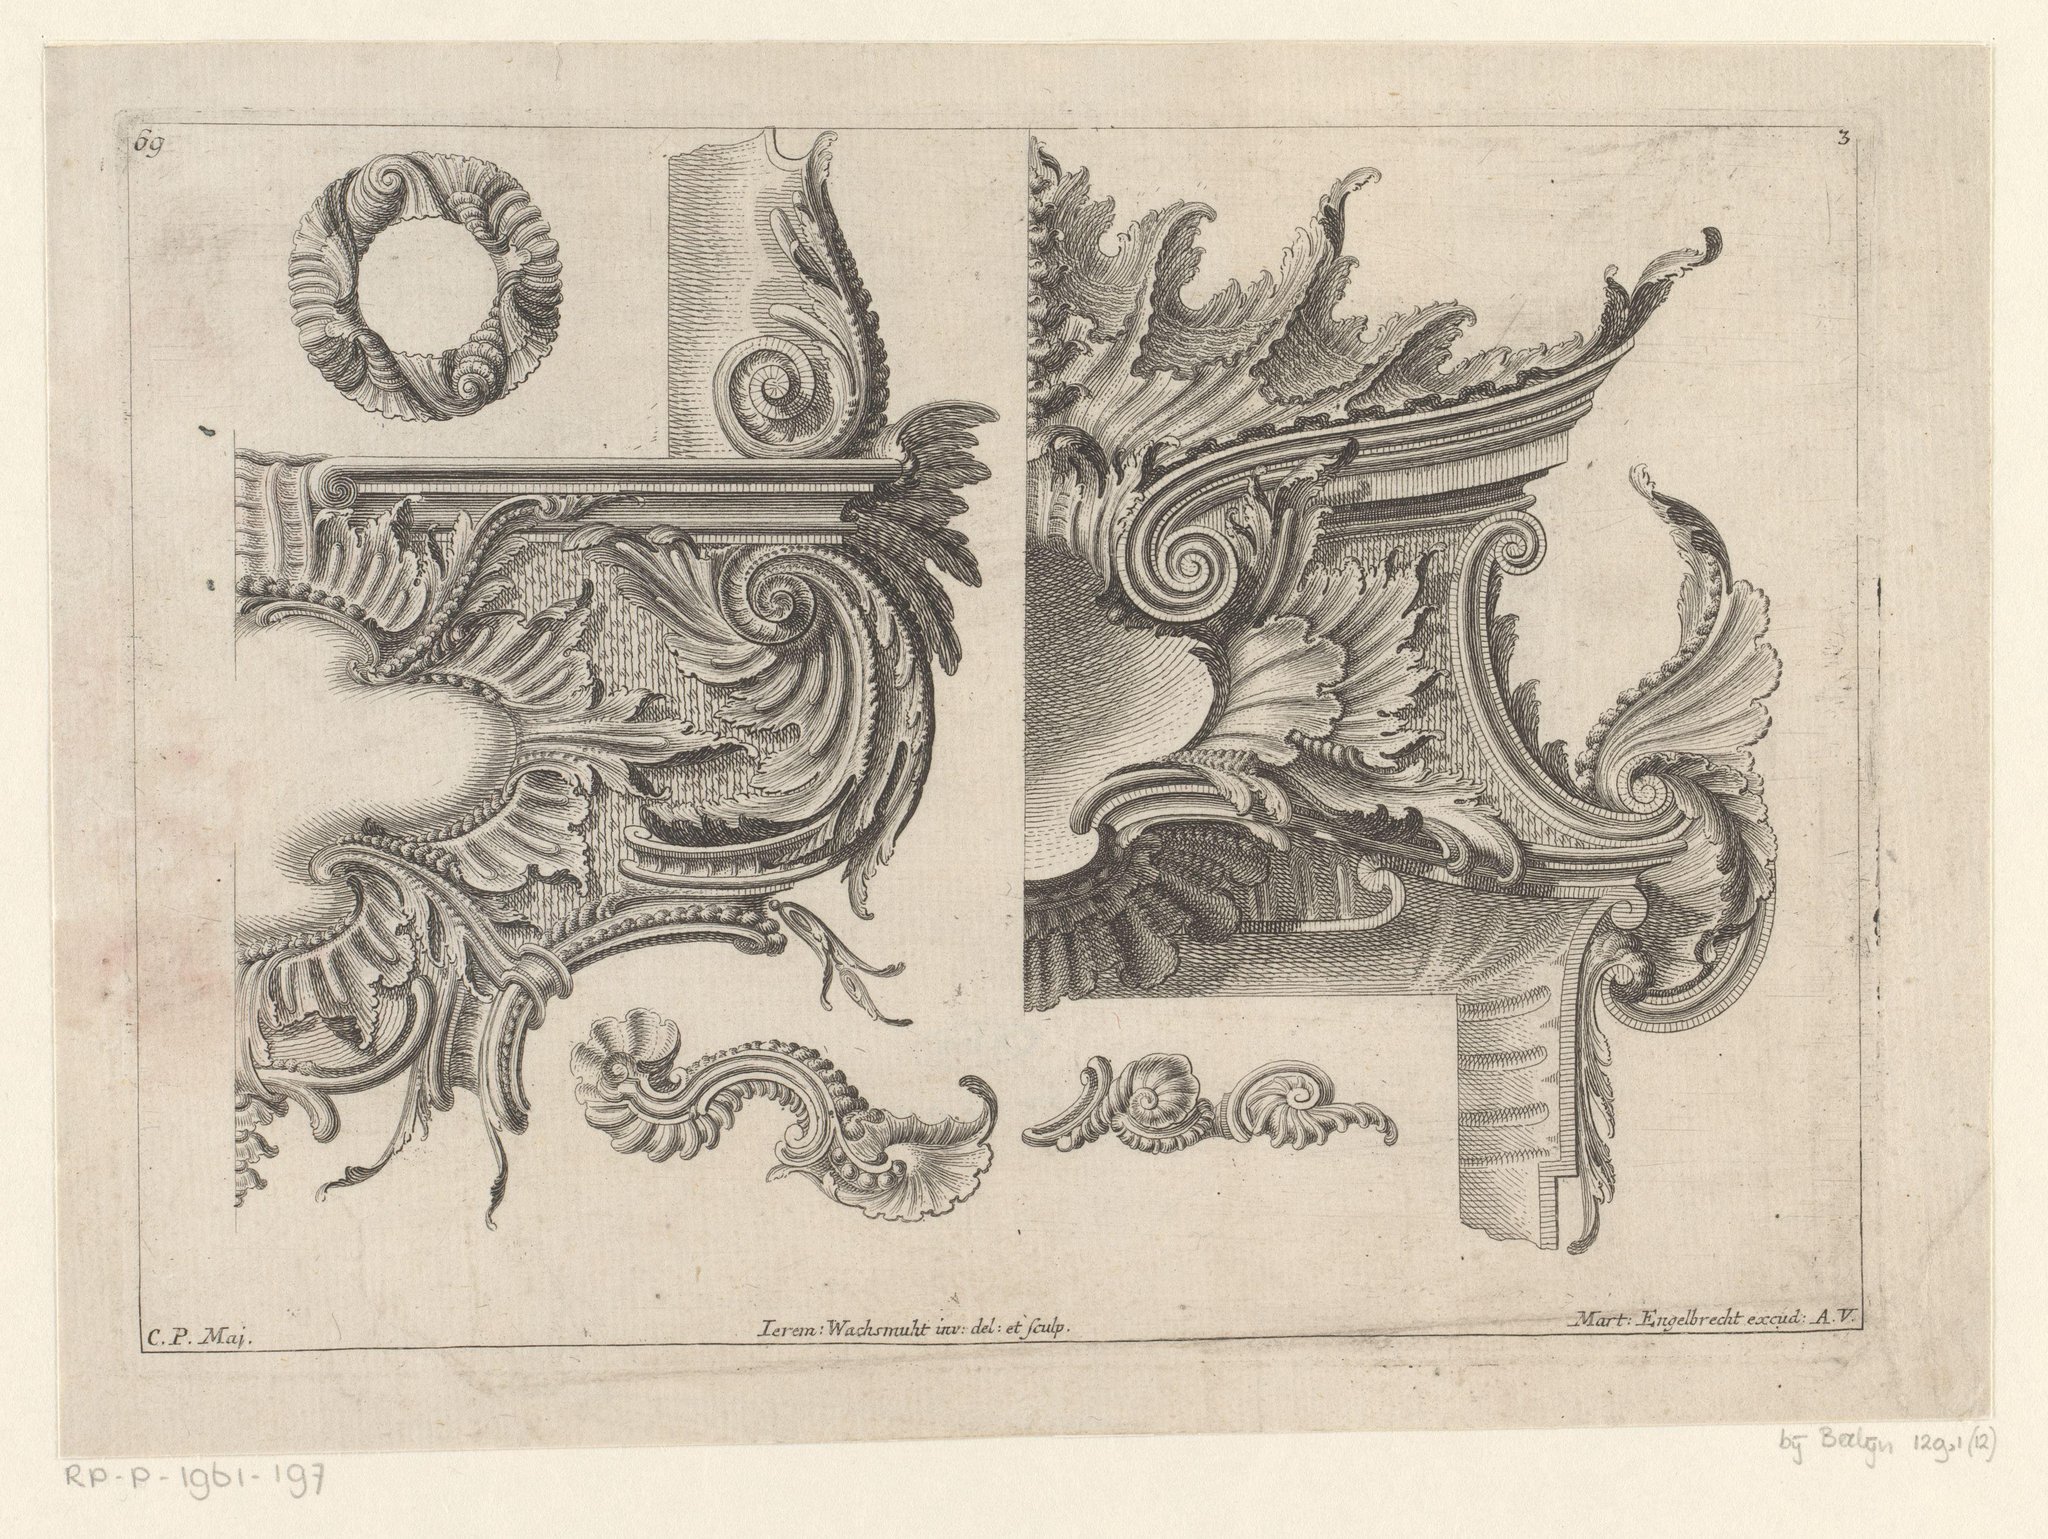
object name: print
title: Unterschidliche Auzierungen zu Thüren und Fenster (...)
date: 1721-1756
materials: paper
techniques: etching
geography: augsburg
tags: rocaille ornament, ornaments ~ art (+ framing decorations)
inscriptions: collector's mark: Lugt 2228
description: Rocaille ornamenten en deur- of raamomlijstingen. Prentnummer 69.